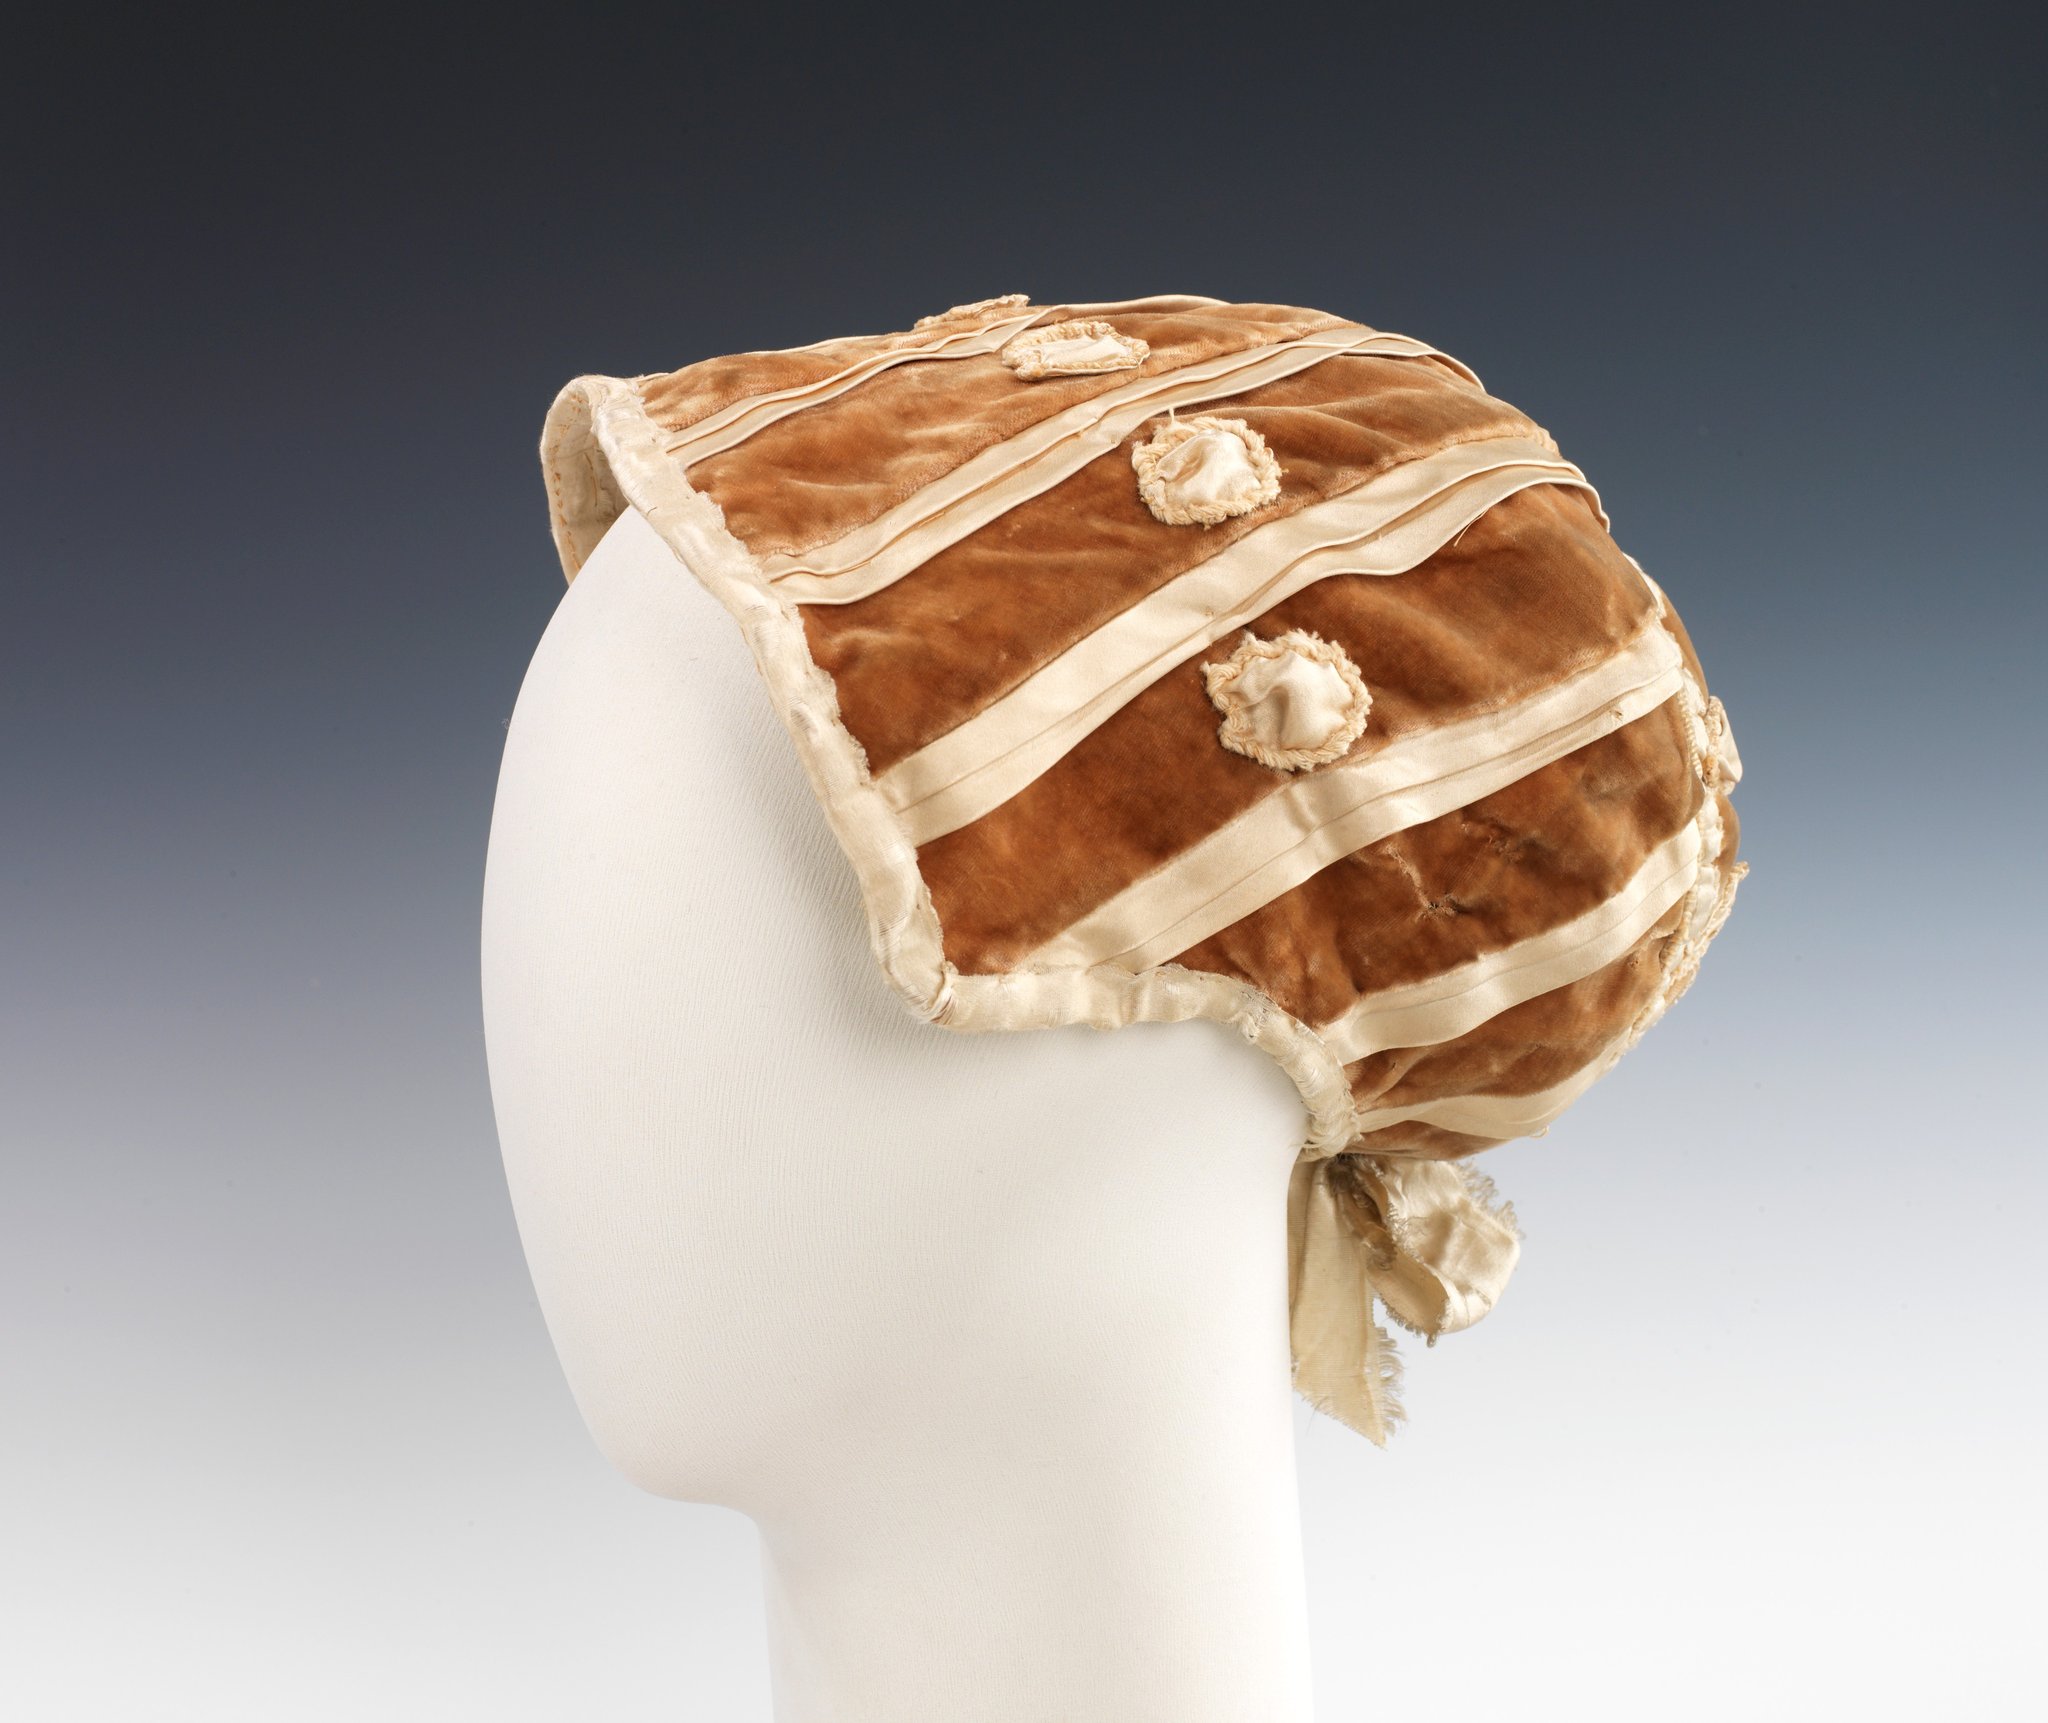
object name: evening bonnet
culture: american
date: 1802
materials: silk